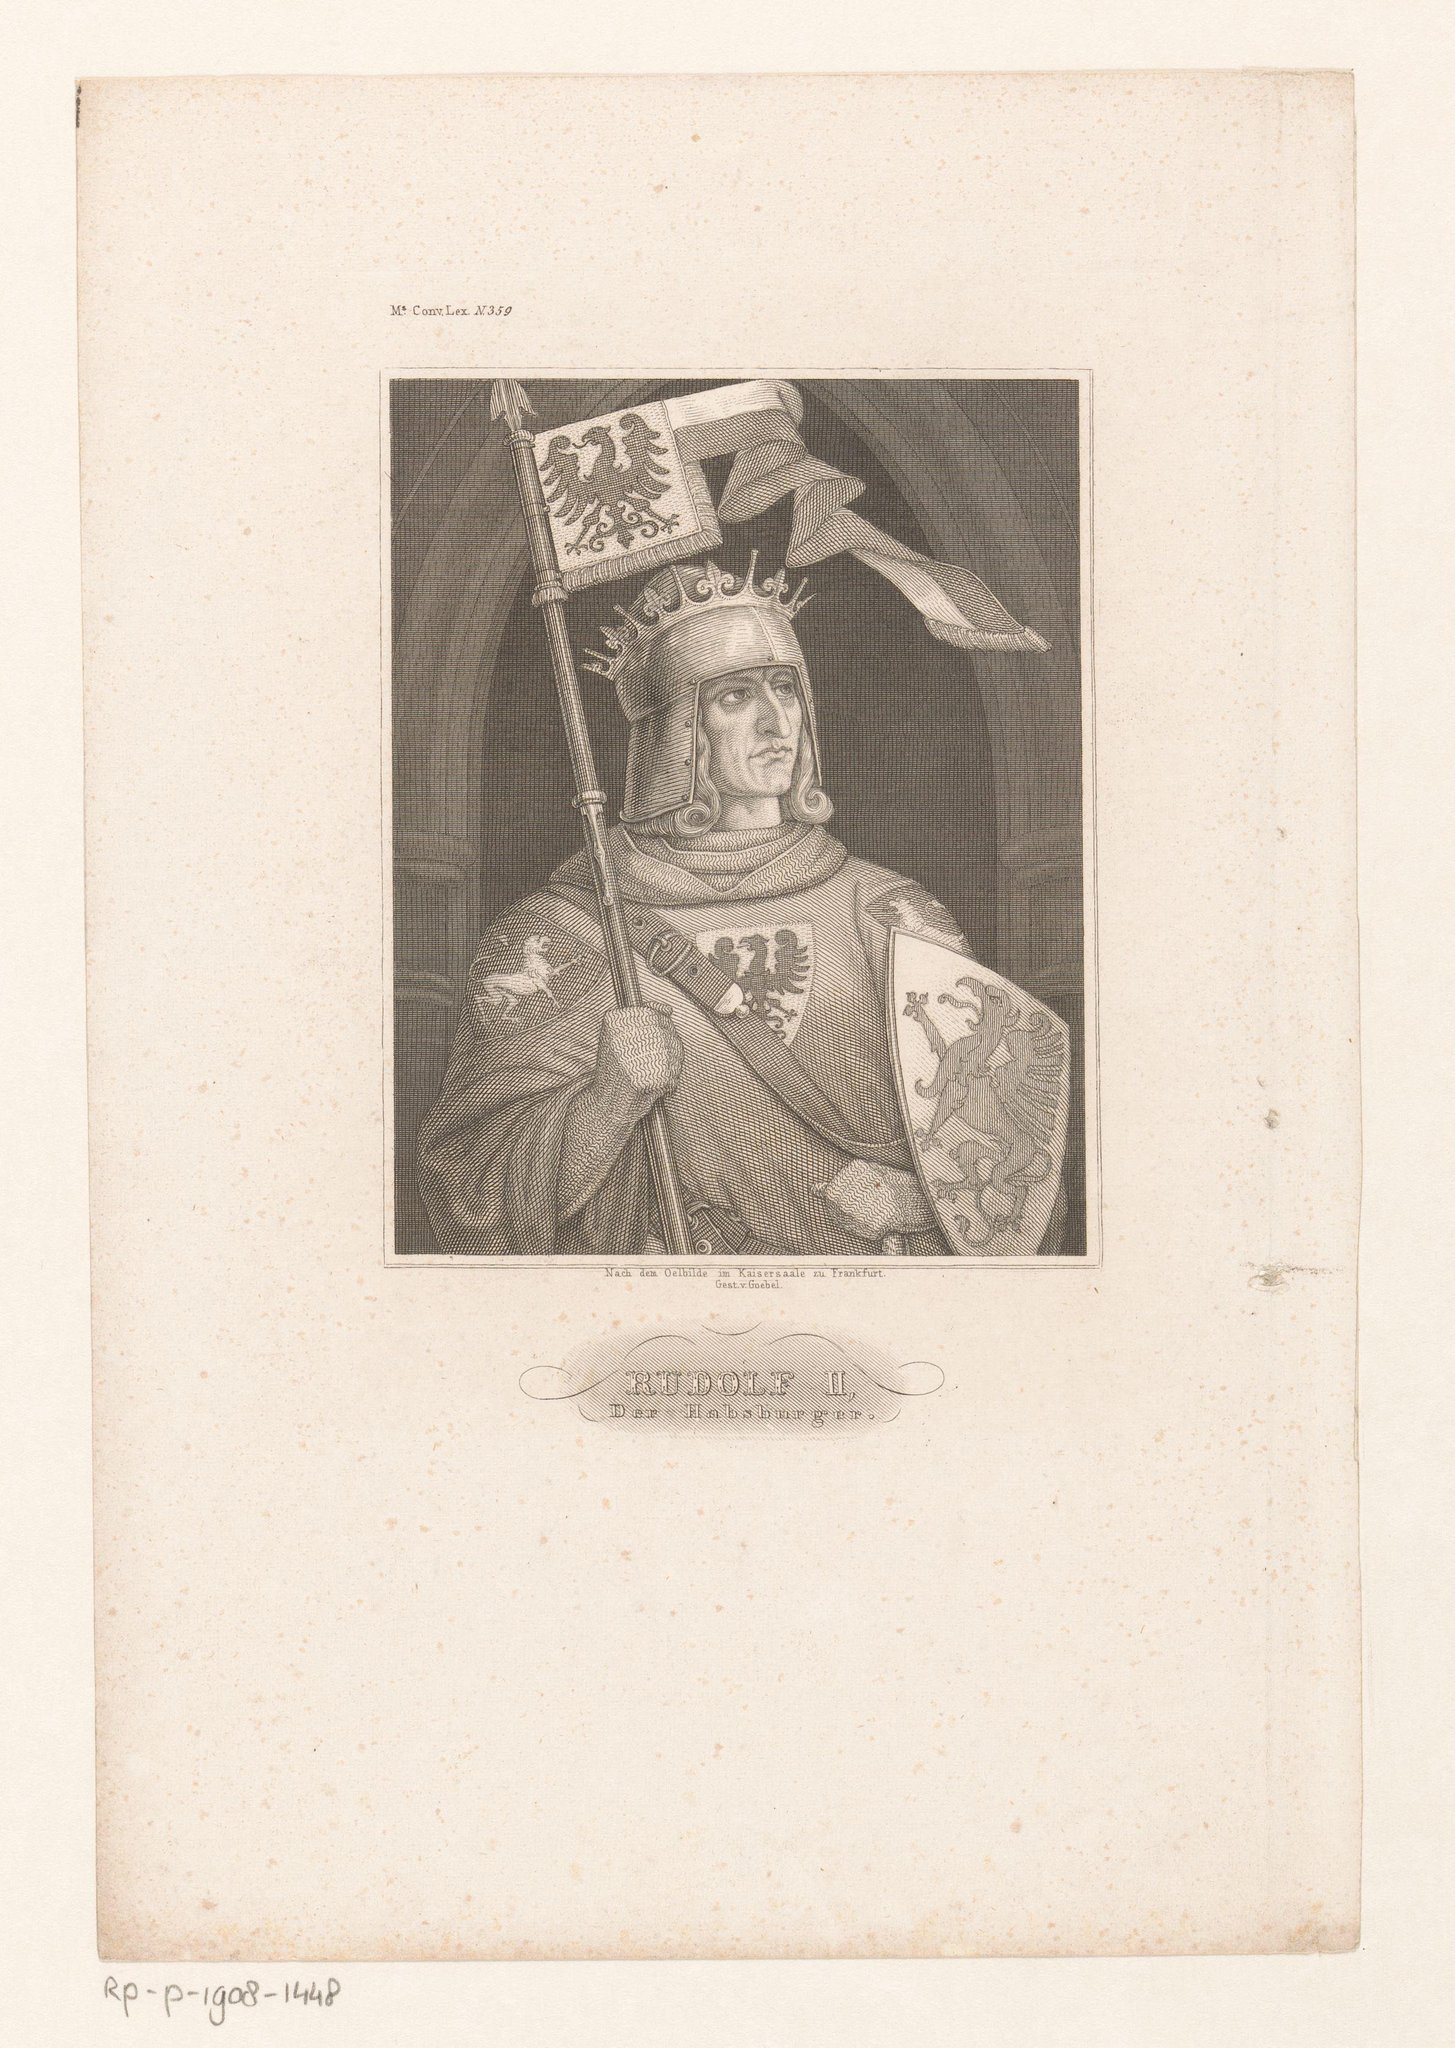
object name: book illustration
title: Portret van Rudolf II van Habsburg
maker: goebel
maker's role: print maker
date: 1840-1855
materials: paper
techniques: etching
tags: vienna, prague, rudolf ii van habsburg (duits keizer), predatory birds: eagle, armour, historical persons, emperor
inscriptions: collector's mark: Lugt 2228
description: Prent afkomstig uit: Conversations-Lexikon für die gebildeten Stände, voor het eerst uitgegeven tussen 1840-1855.